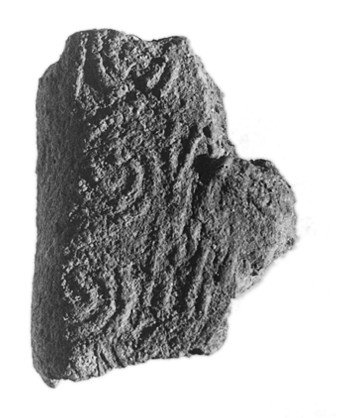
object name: sealing fragment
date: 2030-1640 BCE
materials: clay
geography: egypt